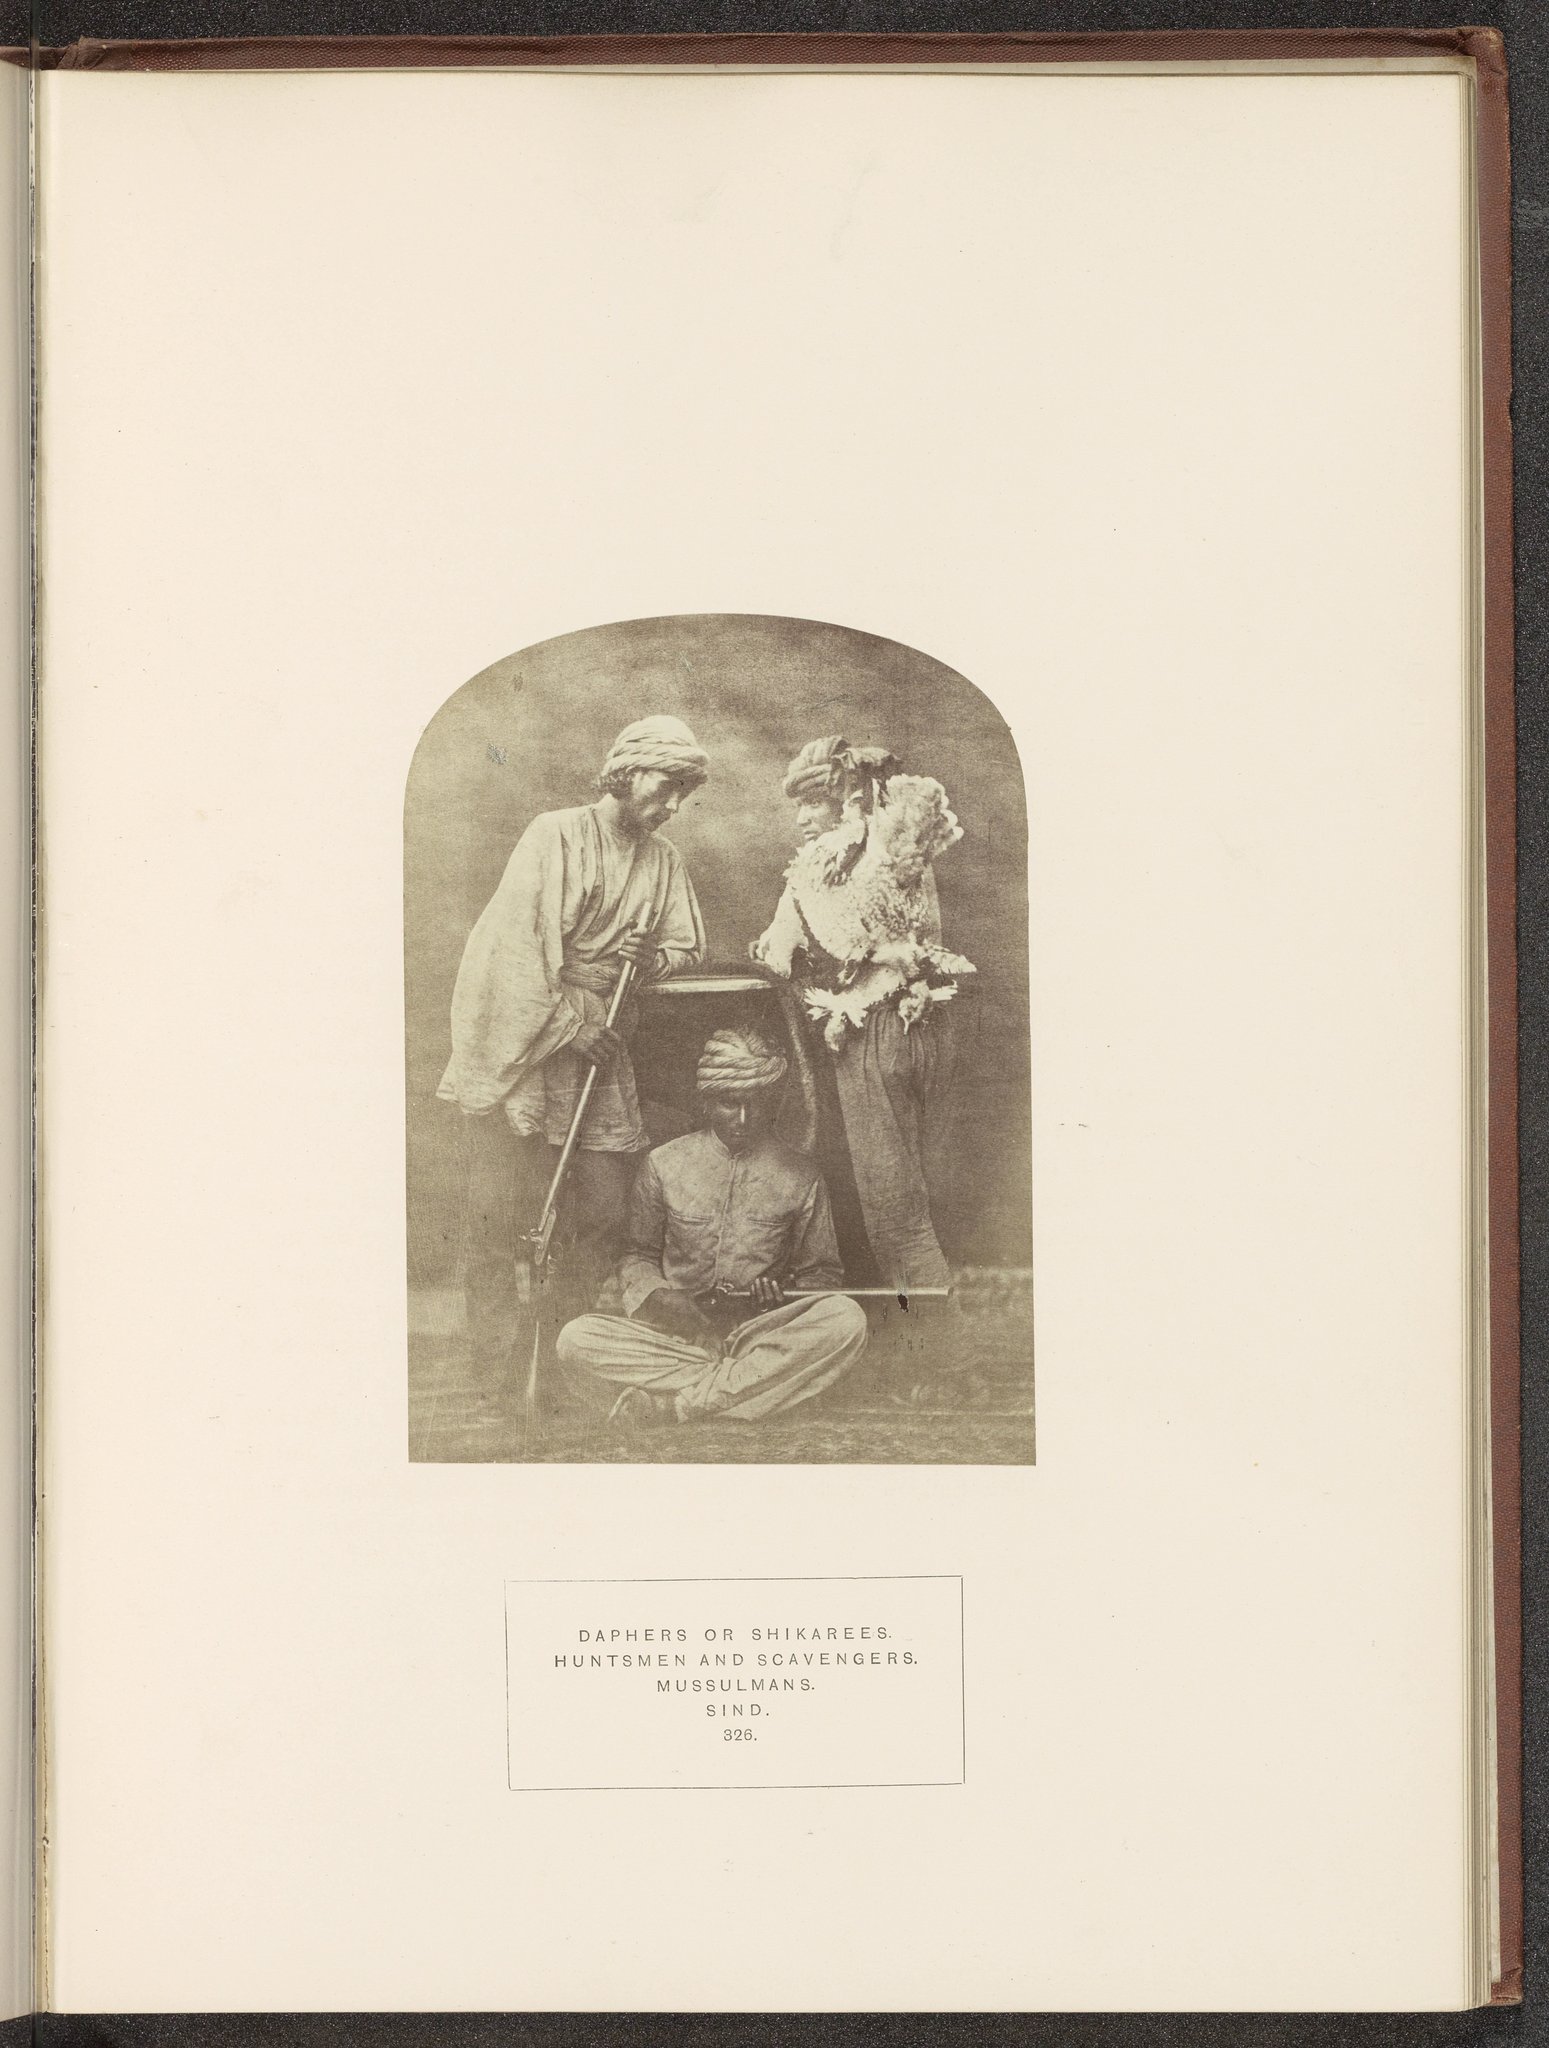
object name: page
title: Portrait of three unknown hunters from Sindh, Pakistan, with a dead bird and rifles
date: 1862-1872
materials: photographic support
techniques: albumen print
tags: hunter, head-gear: turban, firearms: rifle, human races; peoples; nationalities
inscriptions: inscription: ‘DAPHERS OR SHIKAREES./ HUNTSMEN AND SCAVENGERS./ MUSSULMANS./ SIND.’, number: ‘326.’